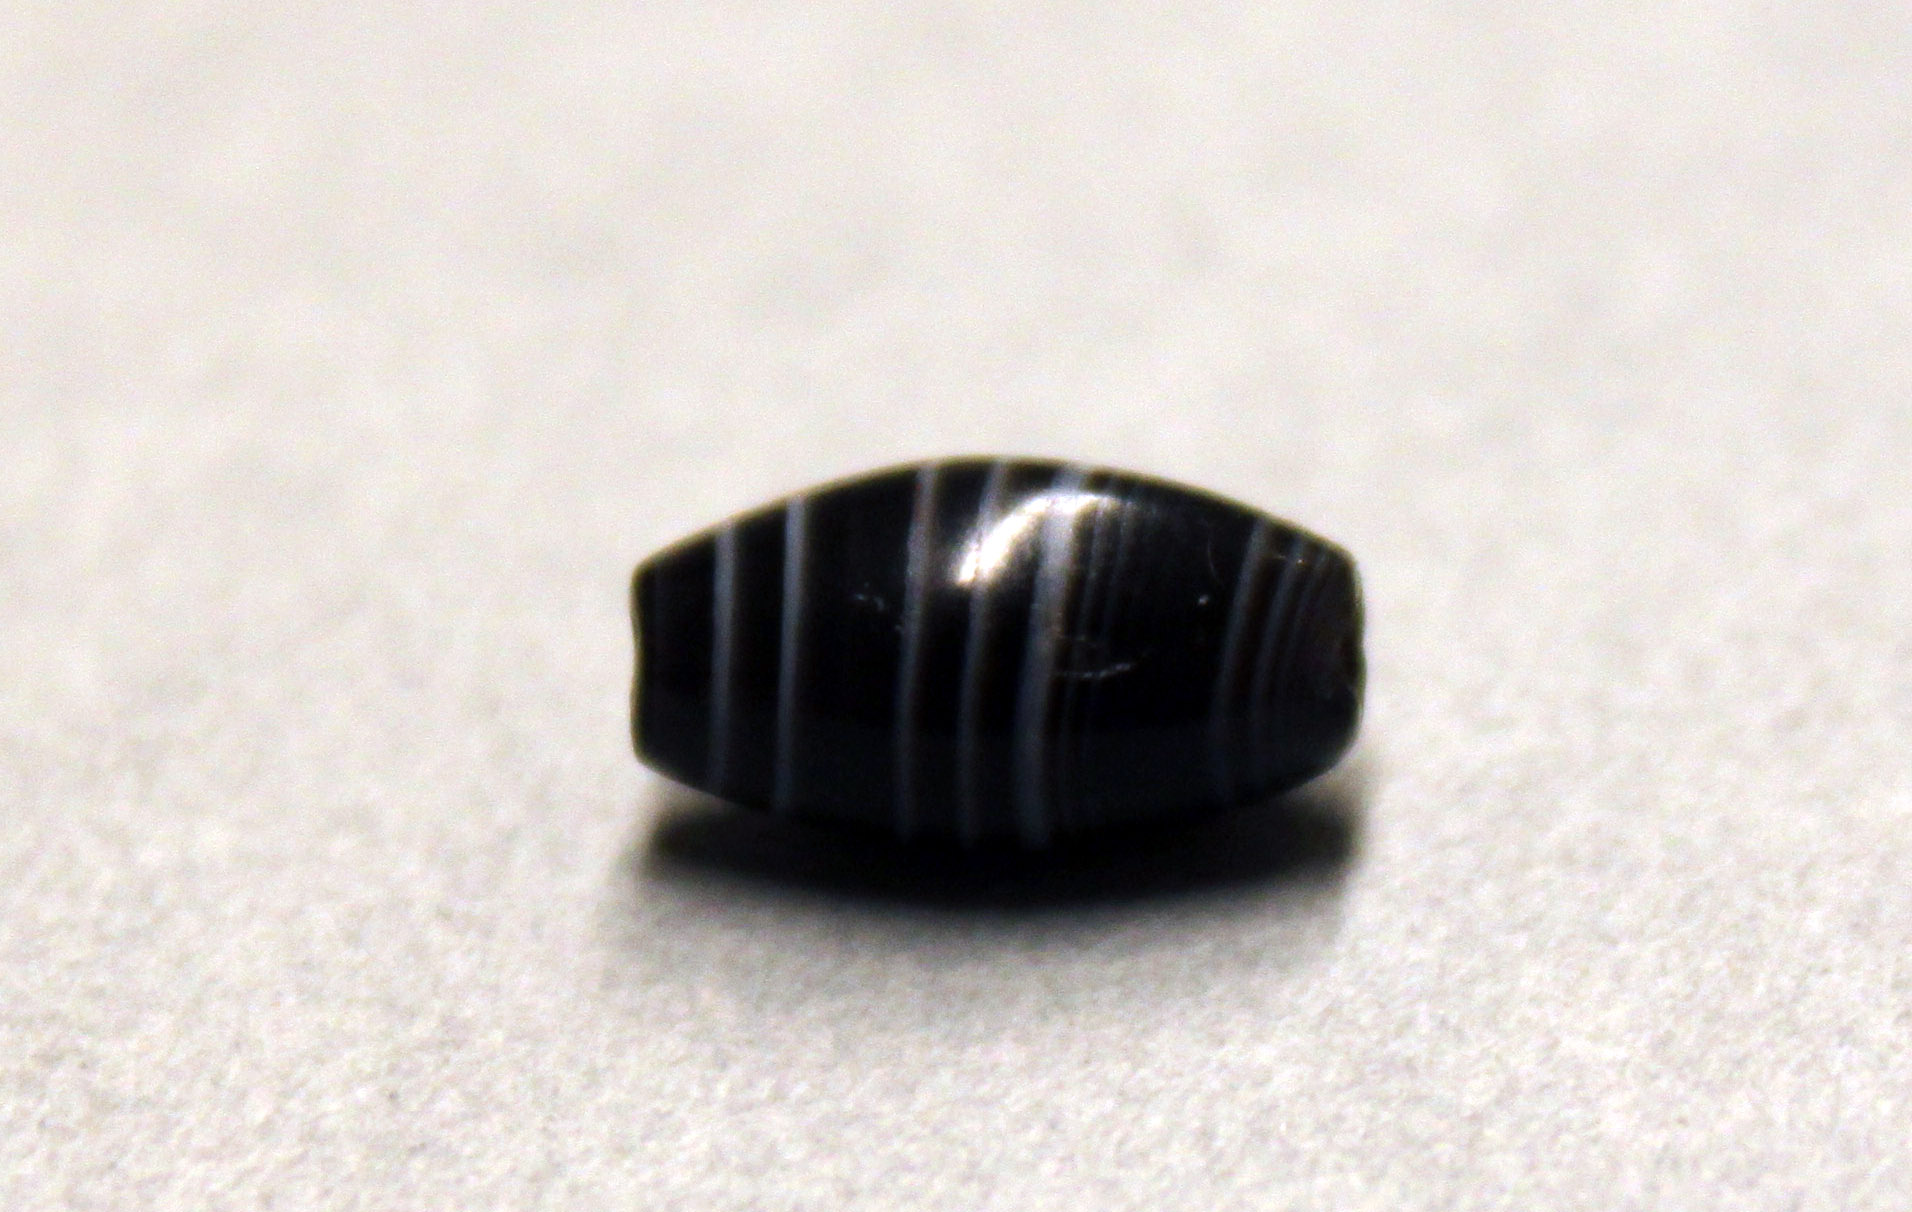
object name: bead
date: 701-1300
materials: stone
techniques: cutting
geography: iran